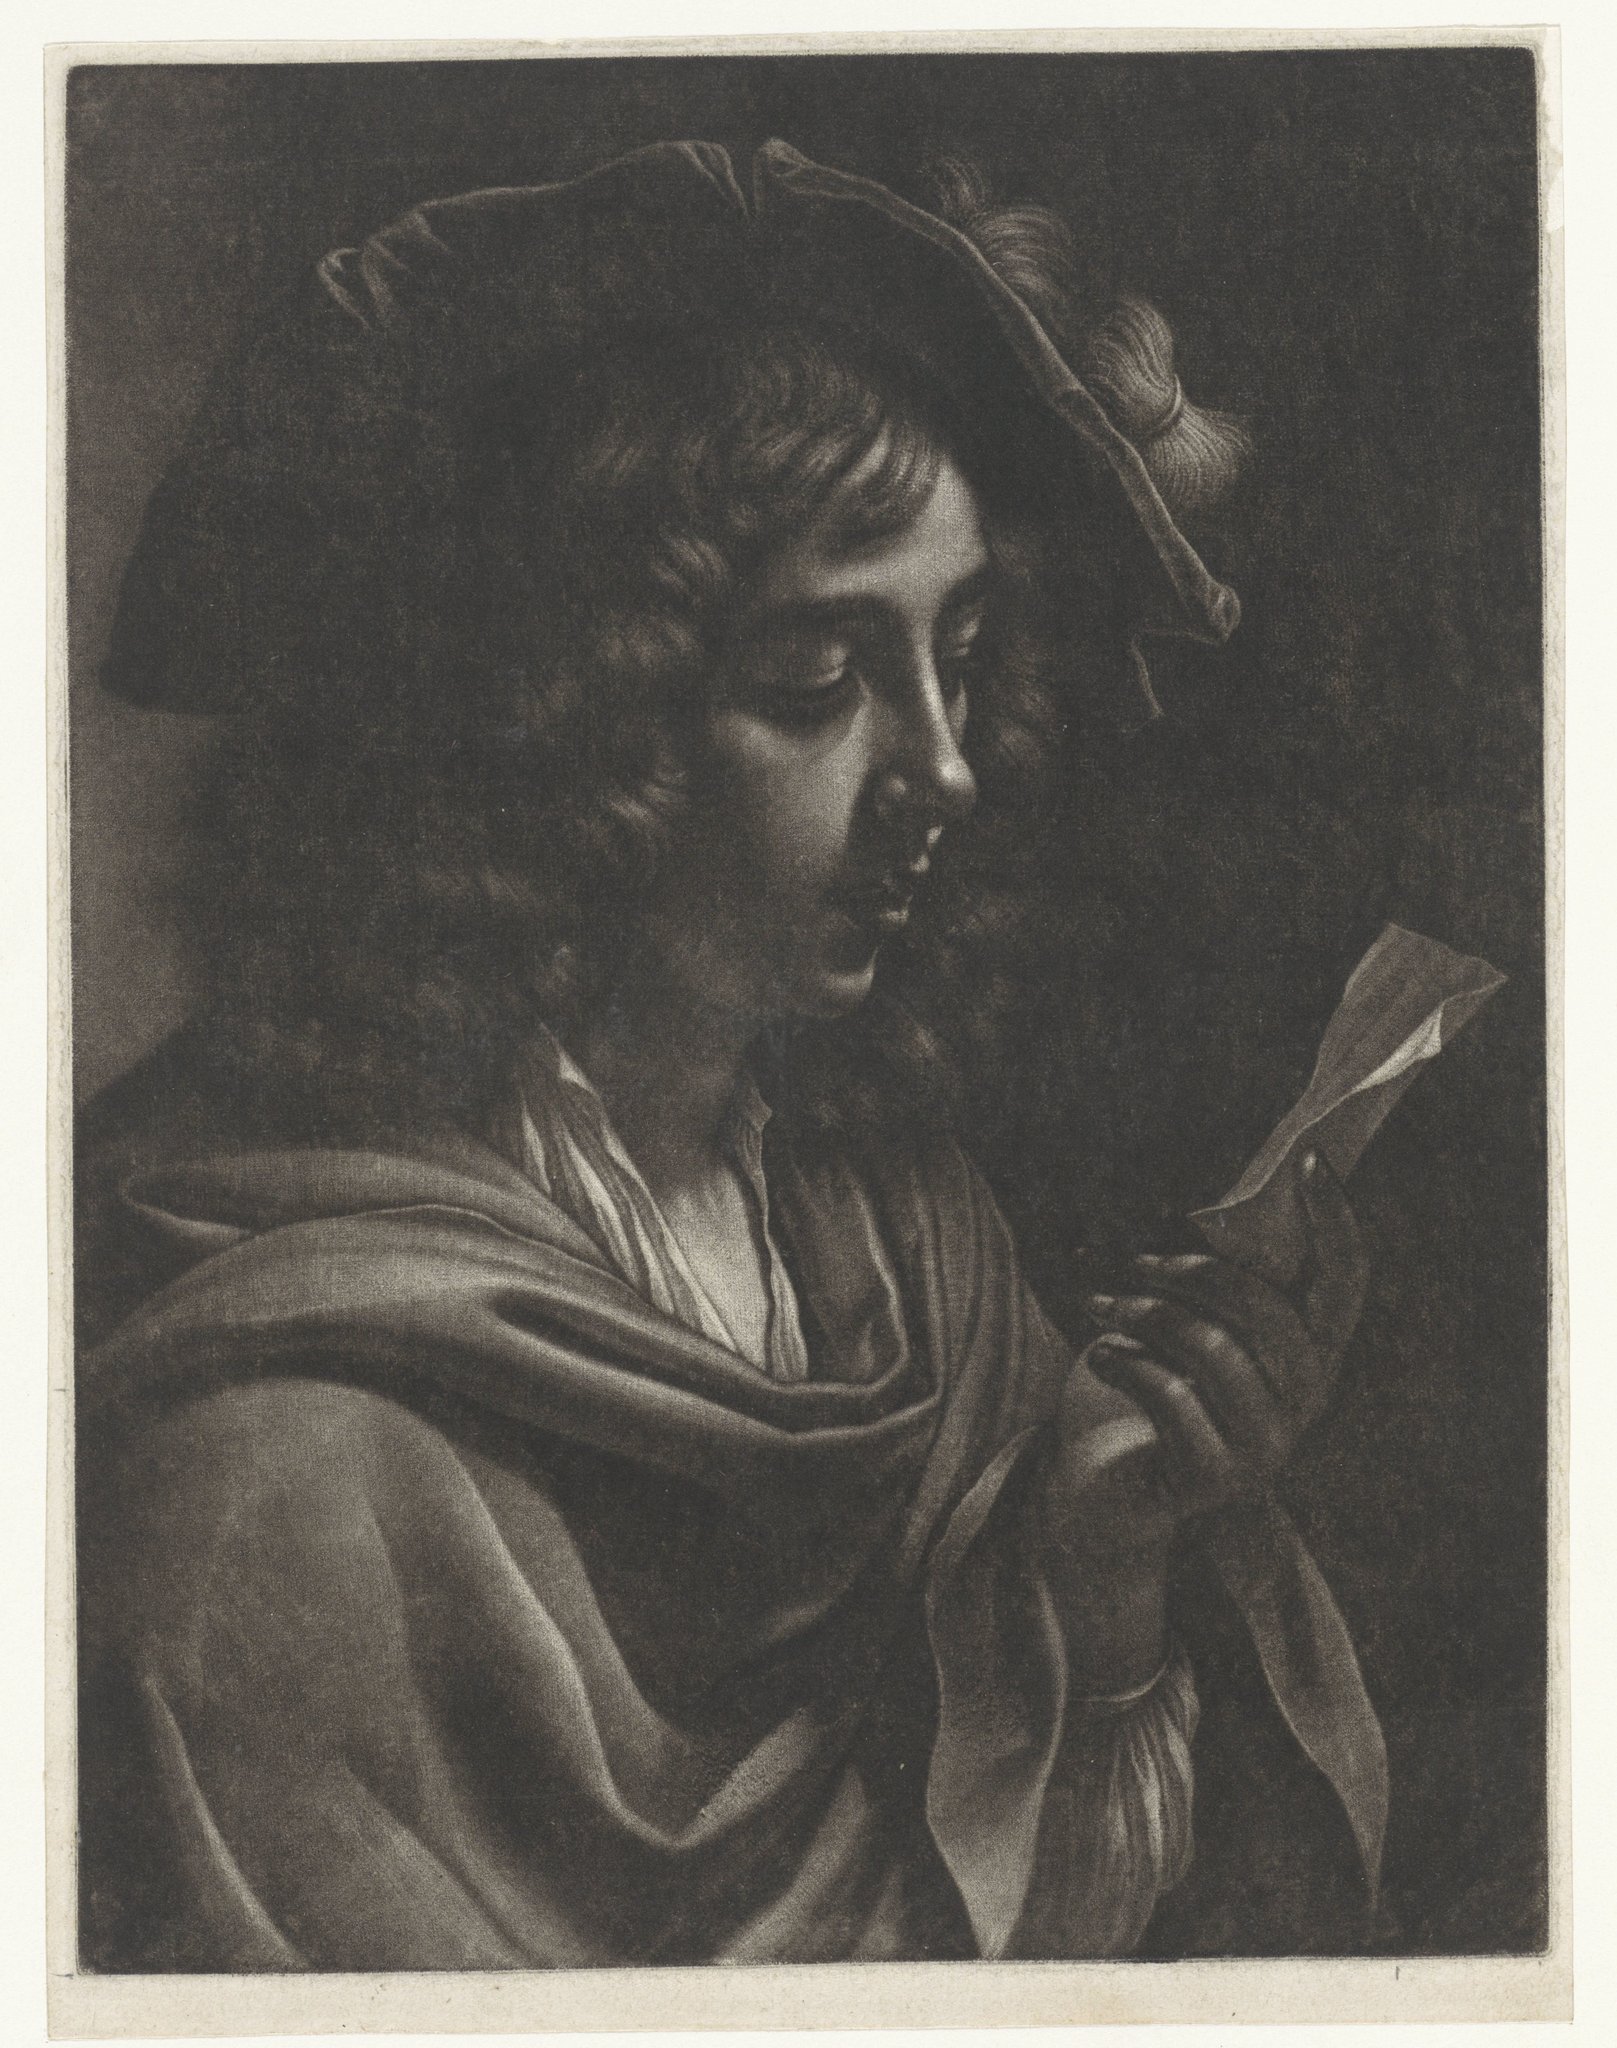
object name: print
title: Brieflezende jongen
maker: wallerant vaillant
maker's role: draughtsman, painter, print maker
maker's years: 1623-1677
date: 1658-1677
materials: paper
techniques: mezzotint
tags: reading, head-gear: hat (+ men's clothes)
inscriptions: collector's mark: Lugt 2228